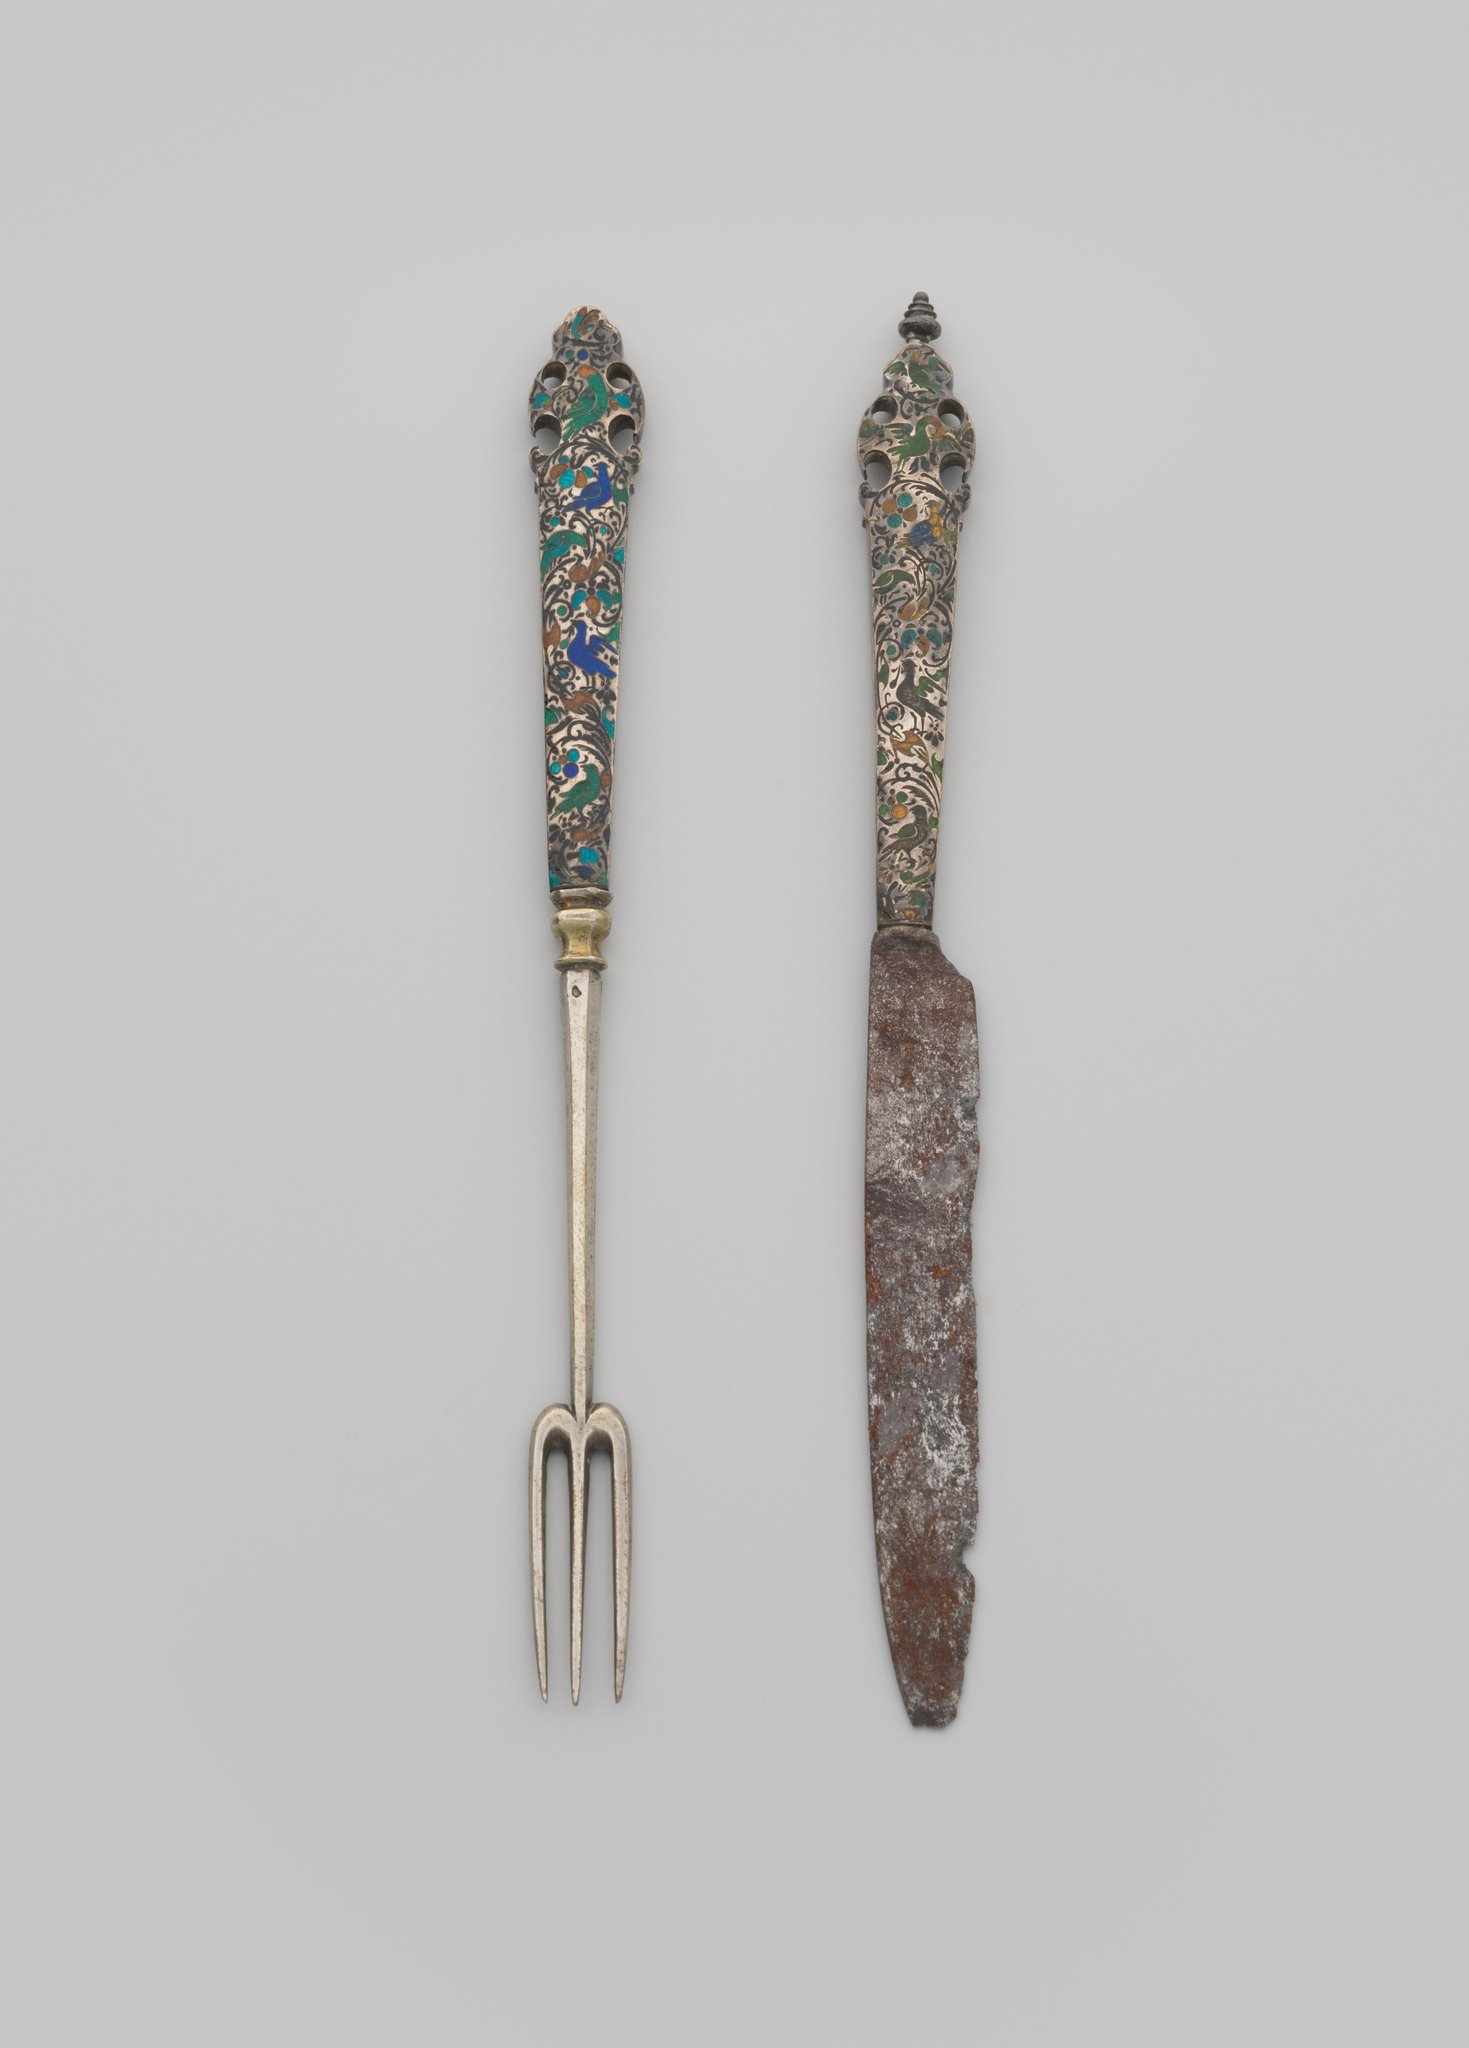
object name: fork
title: Vork van zilver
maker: Anonymous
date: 1600-1615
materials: silver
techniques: gilding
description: Vork van zilver, met 3 tanden. Het heft verbreedt zich naar het uiteinde toe, en is bekroond met opengewerkt rolwerkmotief. Het is versierd met motieven in bass-taille émail.